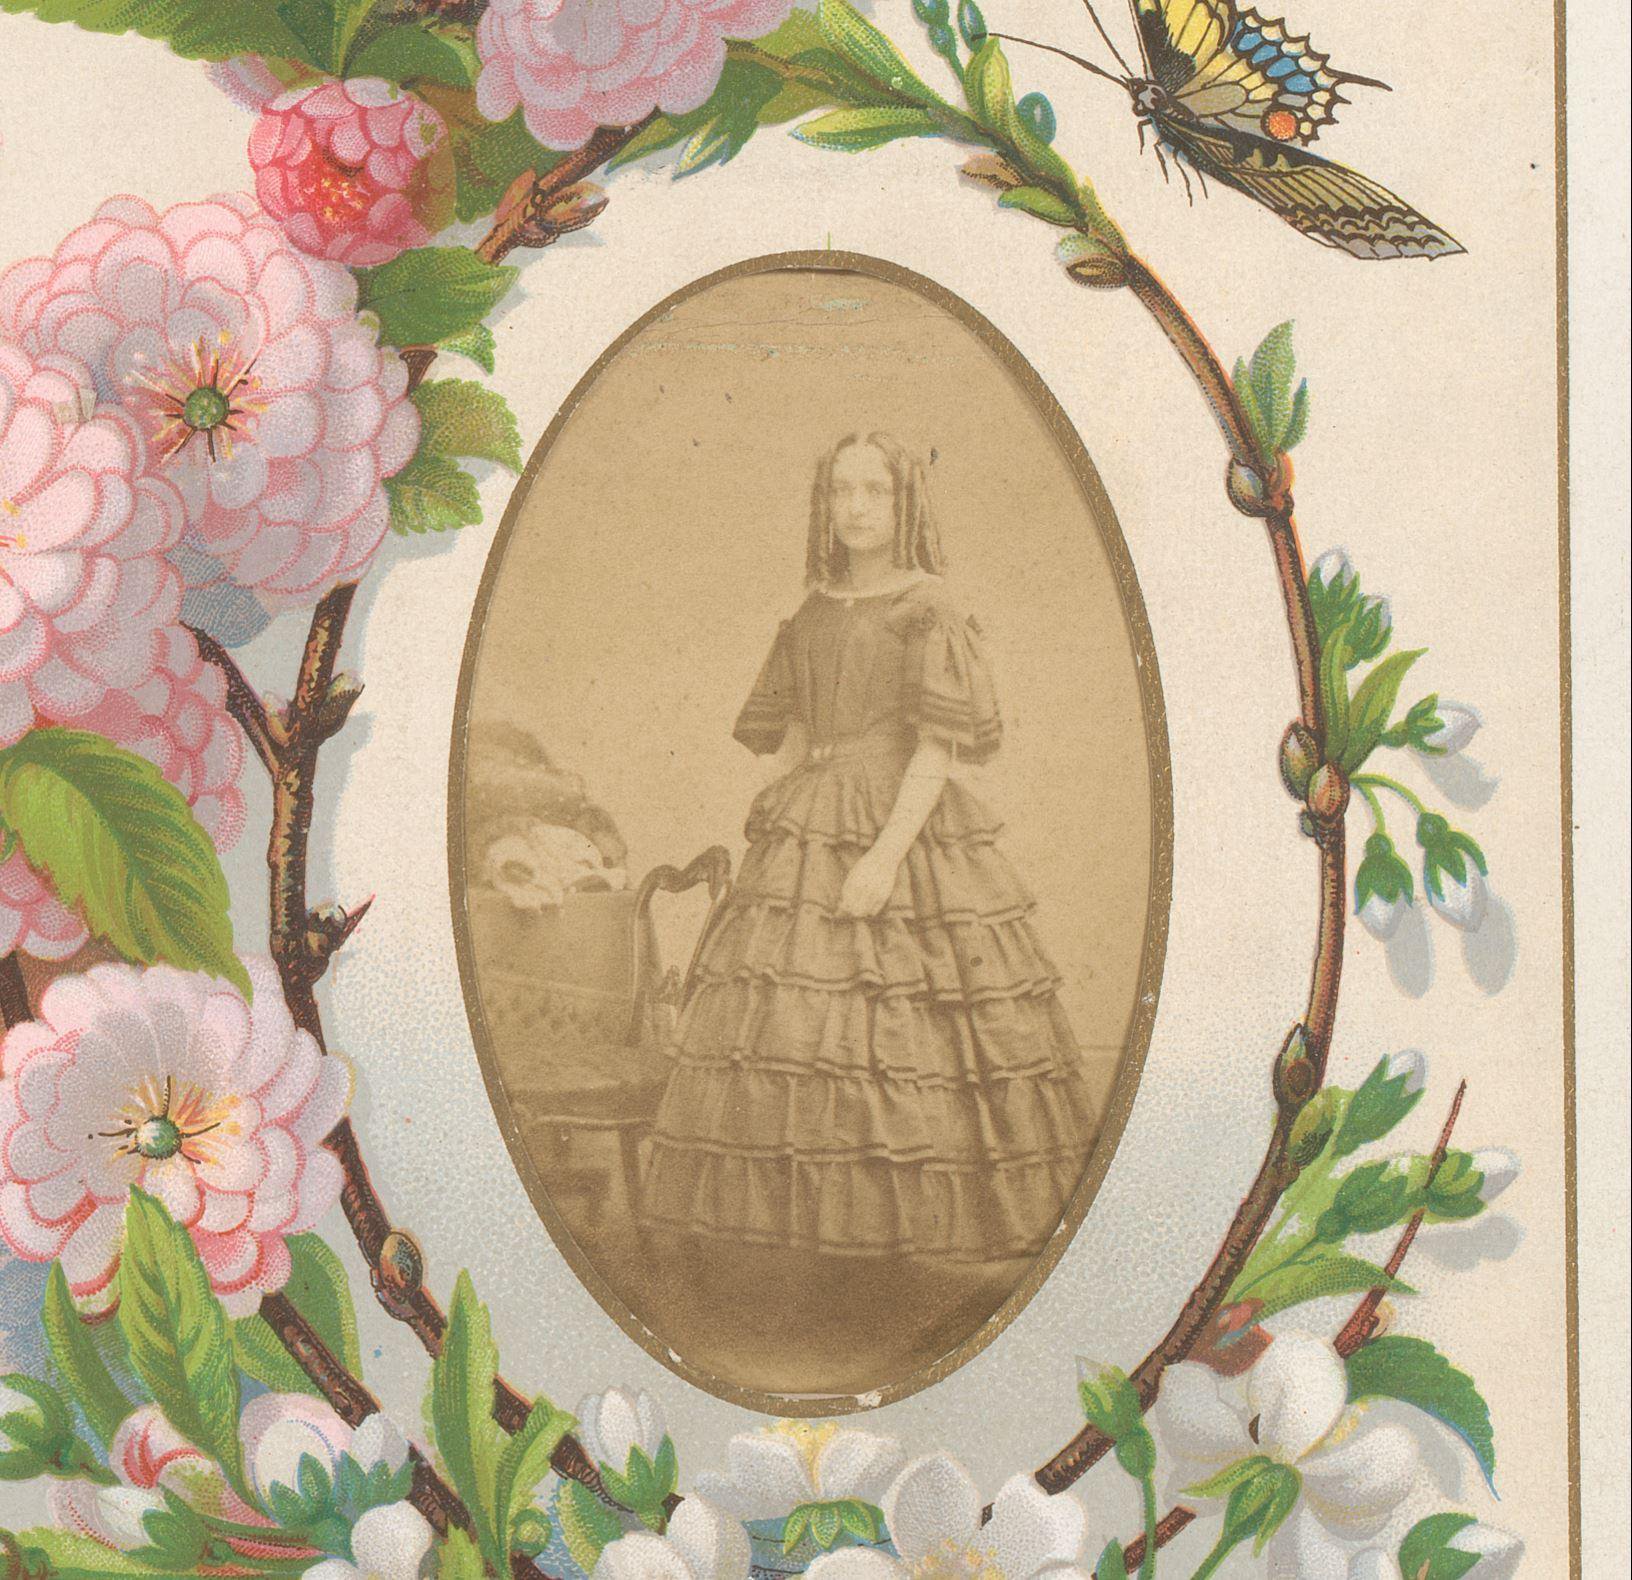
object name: carte de visite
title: Portret van een meisje met pijpenkrullen en een strokenrok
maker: Anonymous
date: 1860-1875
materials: cardboard, paper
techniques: albumen print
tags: historical persons, girl (child between toddler and youth)